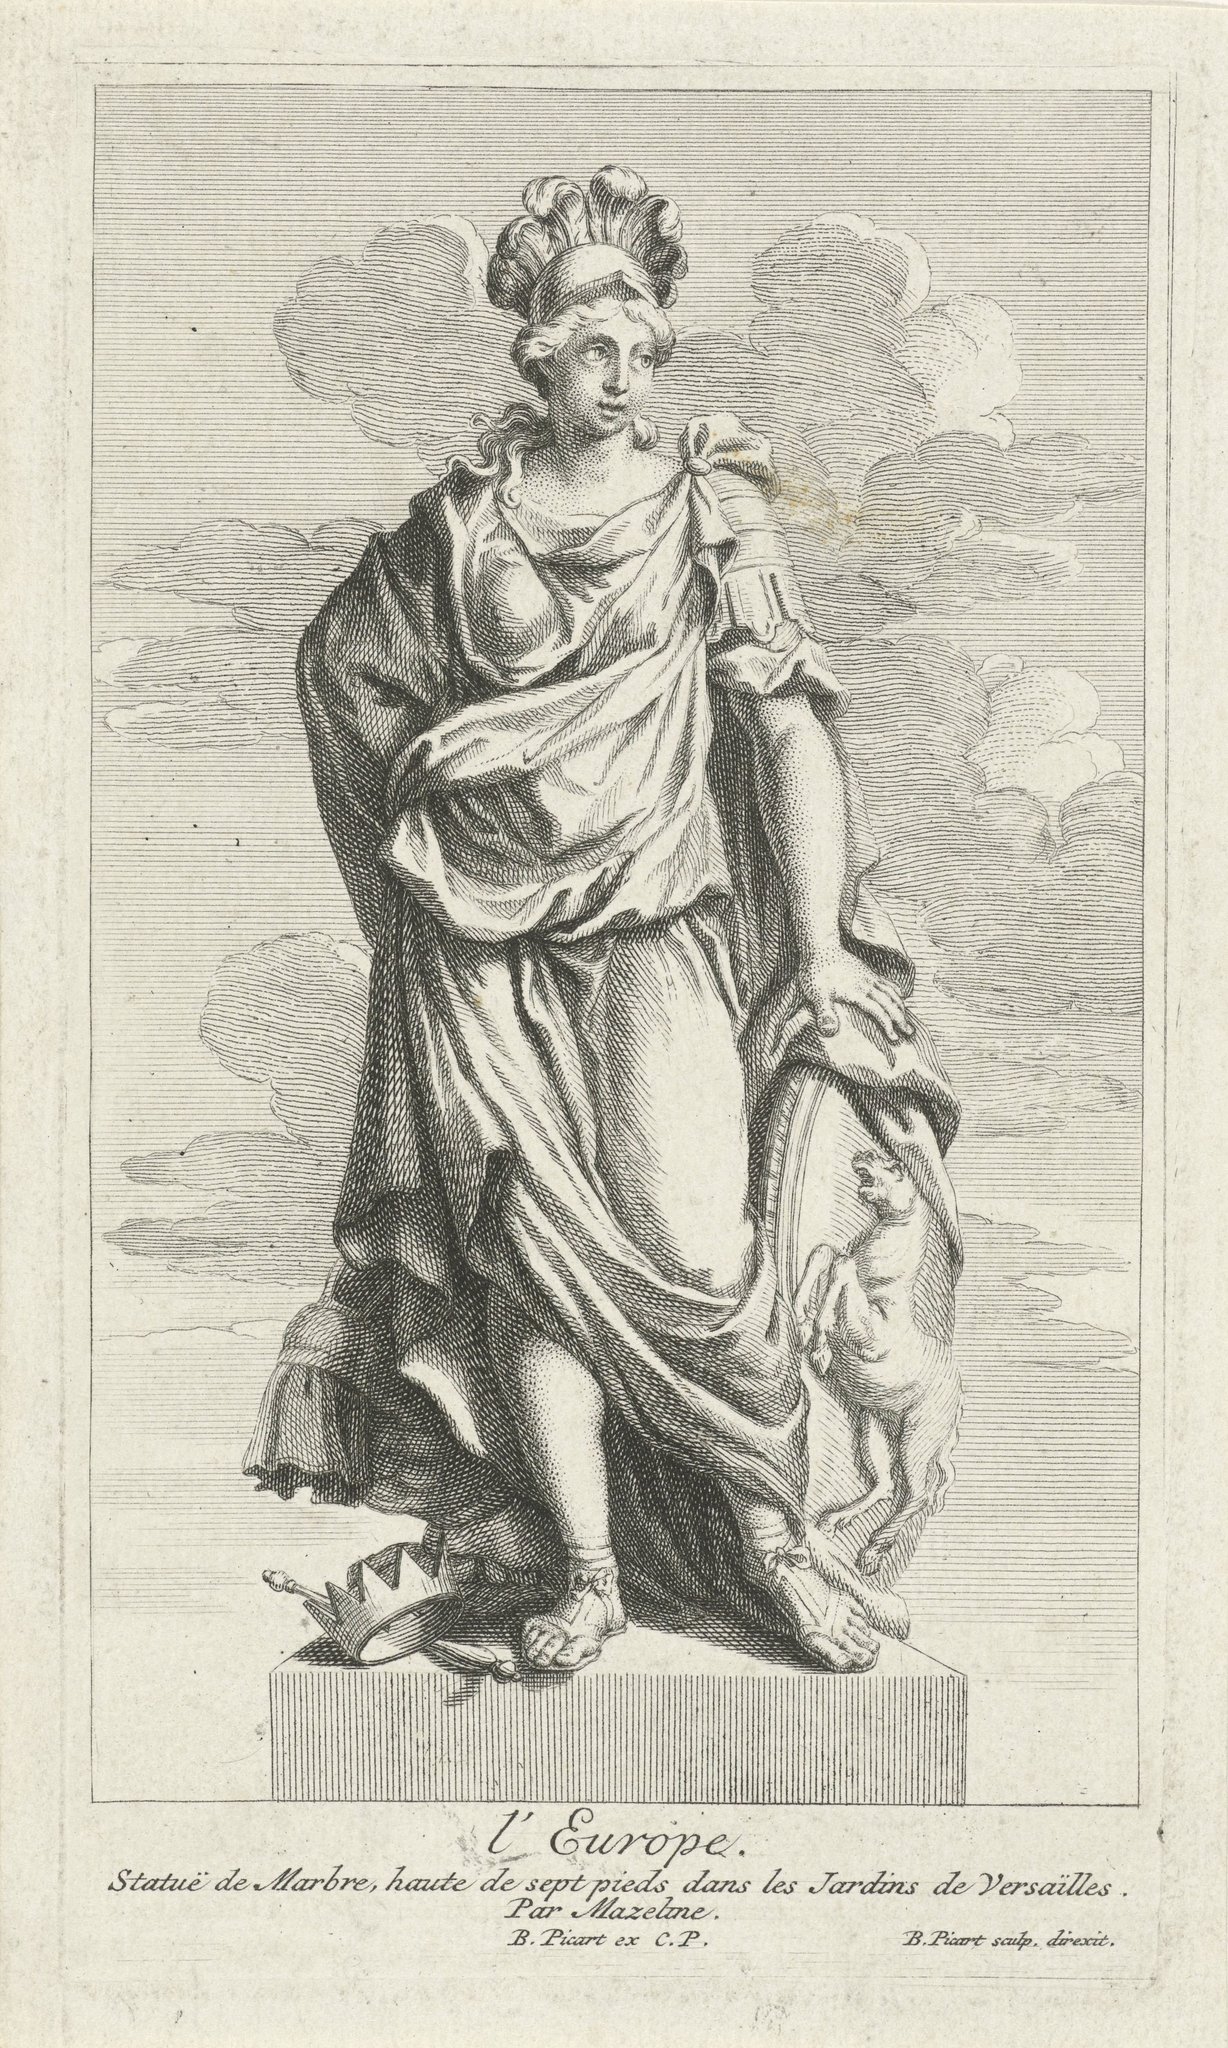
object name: print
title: Europa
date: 1709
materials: paper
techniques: engraving, etching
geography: paris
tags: europe represented allegorically; 'europa' (ripa), piece of sculpture, reproduction of a piece of sculpture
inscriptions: collector's mark: Lugt 240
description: Standbeeld in de tuinen van Versailles. De vrouwelijke personificatie van Europa, een schild waarop een paard in de hand als verwijzing naar haar overmacht in de oorlog. Aan haar voeten een kroon en een scepter. In de marge een onderschrift in het Frans.